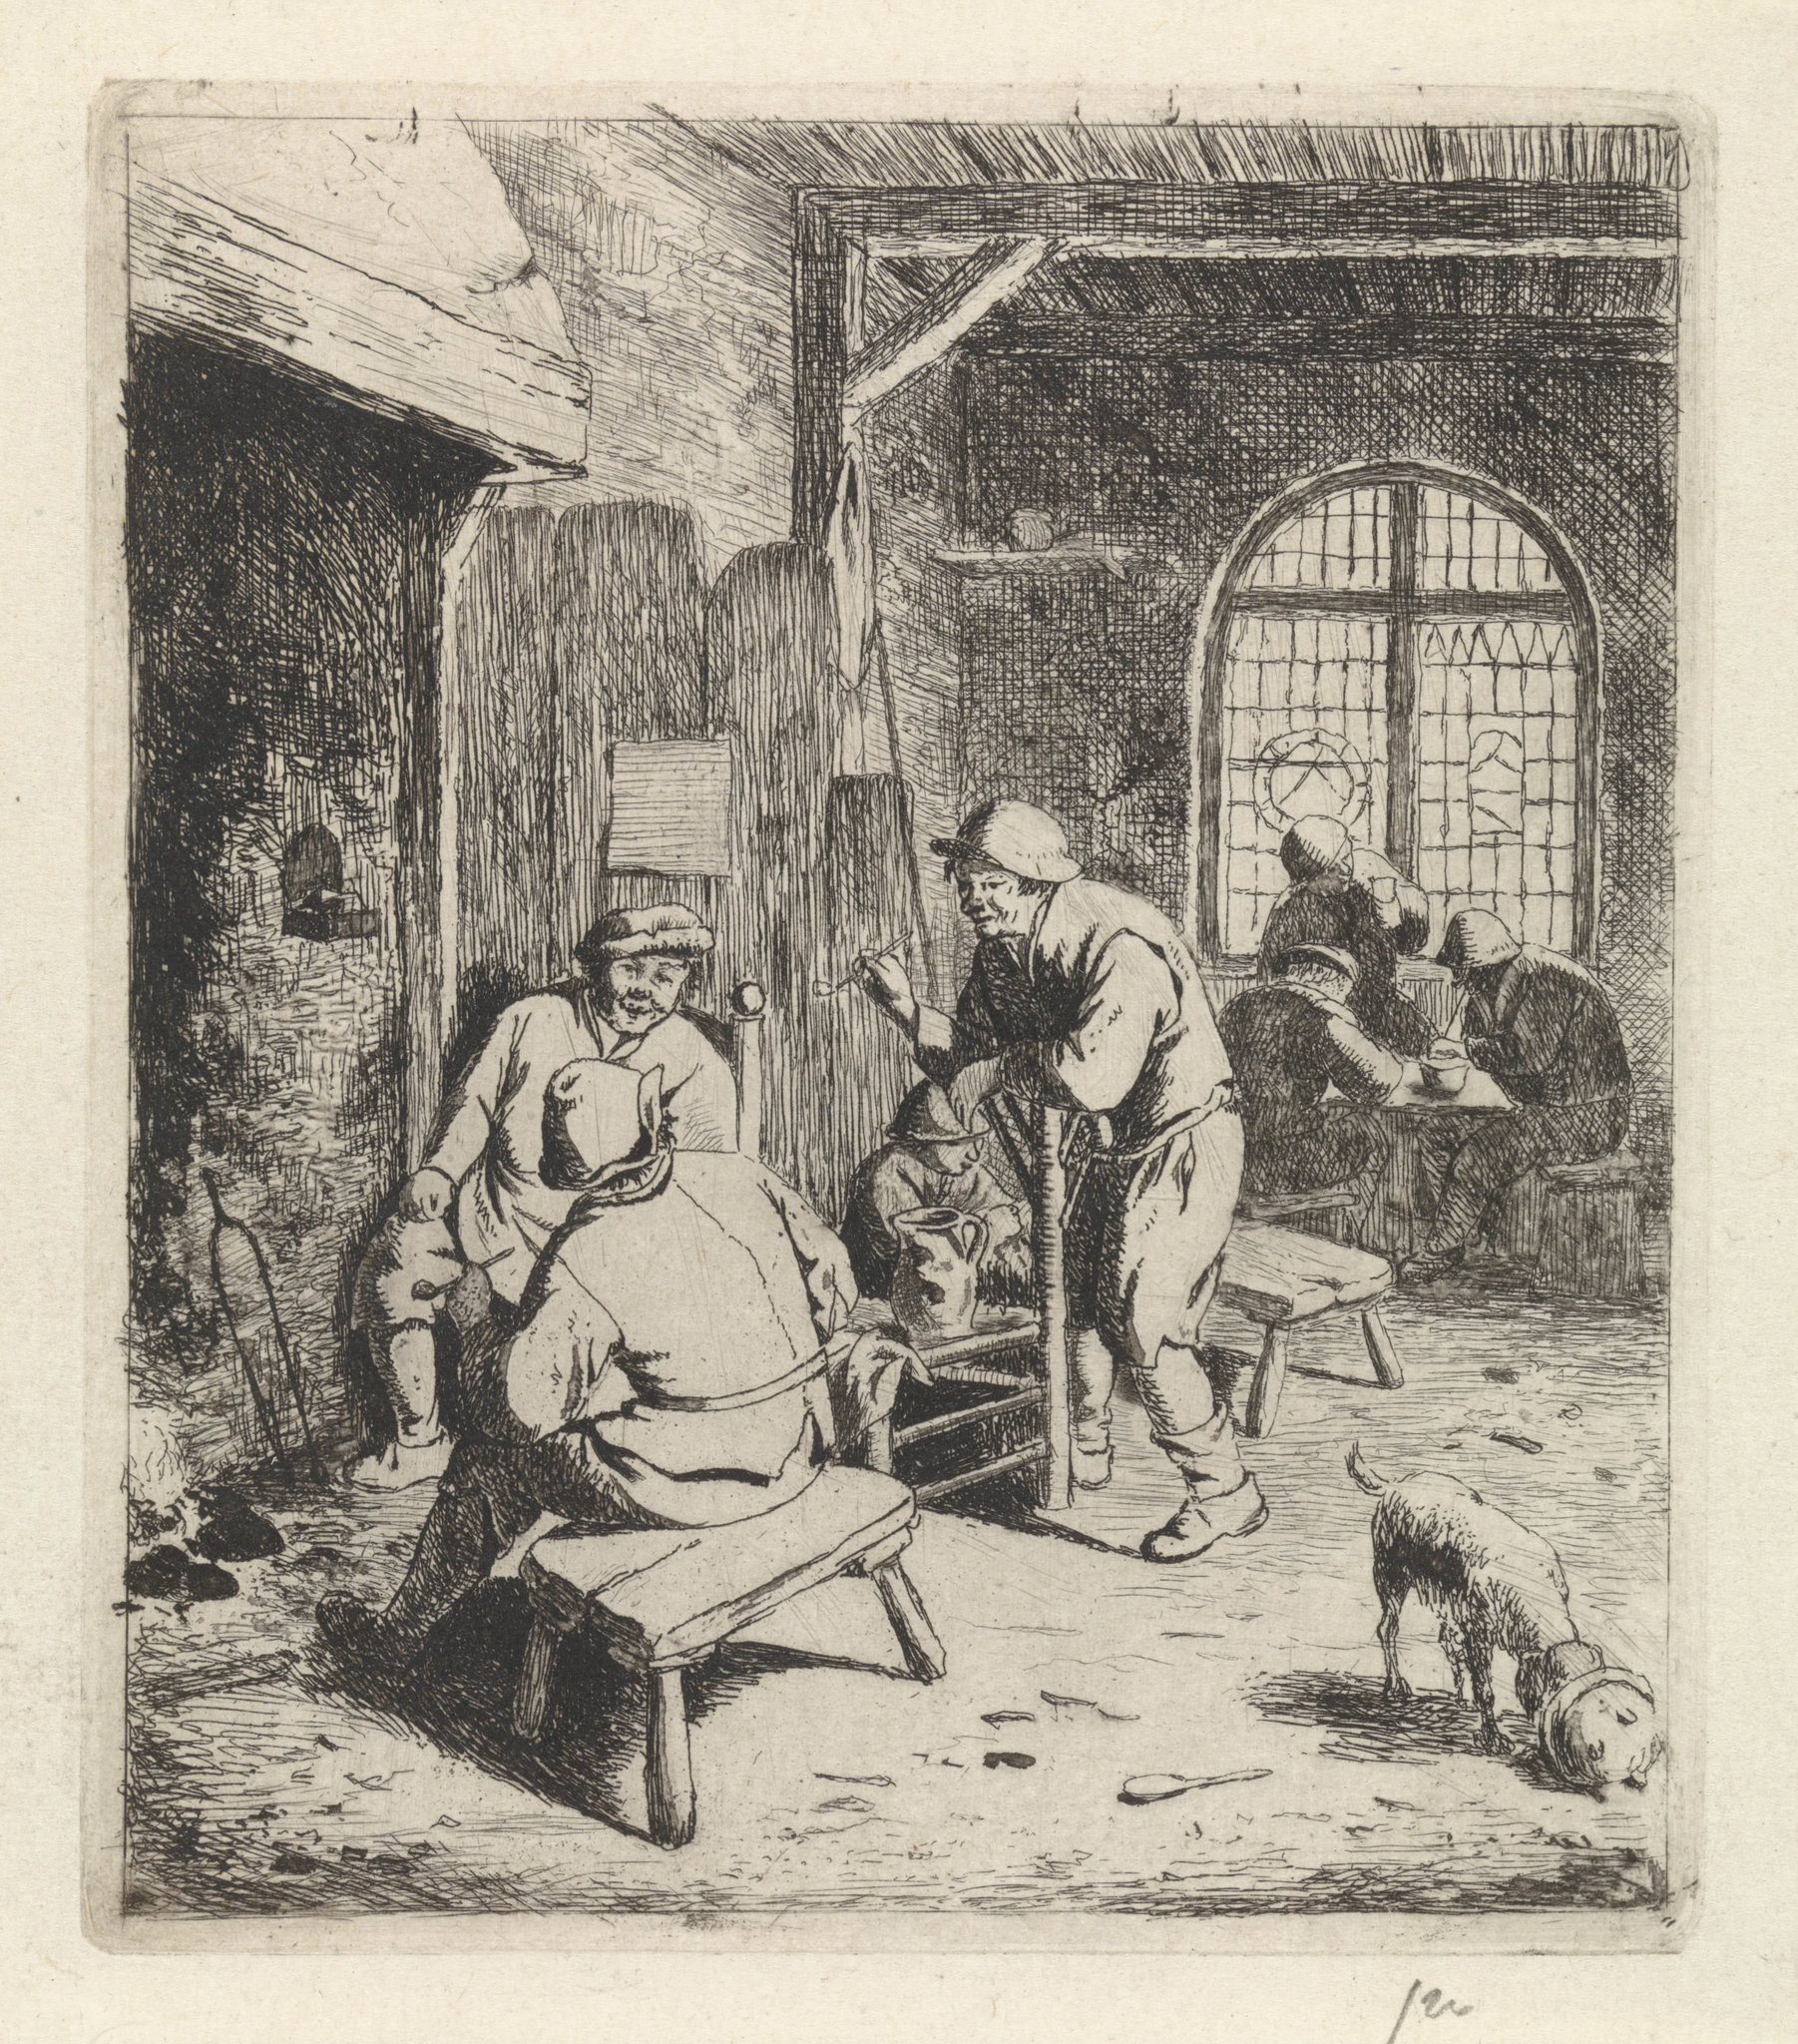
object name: print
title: Herberginterieur met rokende en drinkende boeren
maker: johannes christiaan janson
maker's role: draughtsman, painter, print maker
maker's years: 1763-1823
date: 1778-1823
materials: paper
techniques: etching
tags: inn, coffee-house, public house, etc., tobacco (+ taking (particular) foodstuffs: eating, drinking, smoking, chewing, etc.)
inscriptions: collector's mark: Lugt 240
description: Herberginterieur met rokende boeren bij een schouw. Eén van hen zittend op een kruk, op de rug gezien. Rechts op de voorgrond een hond, etend uit een pot. Op de achtergrond drie drinkende boeren, zittend aan een tafel.